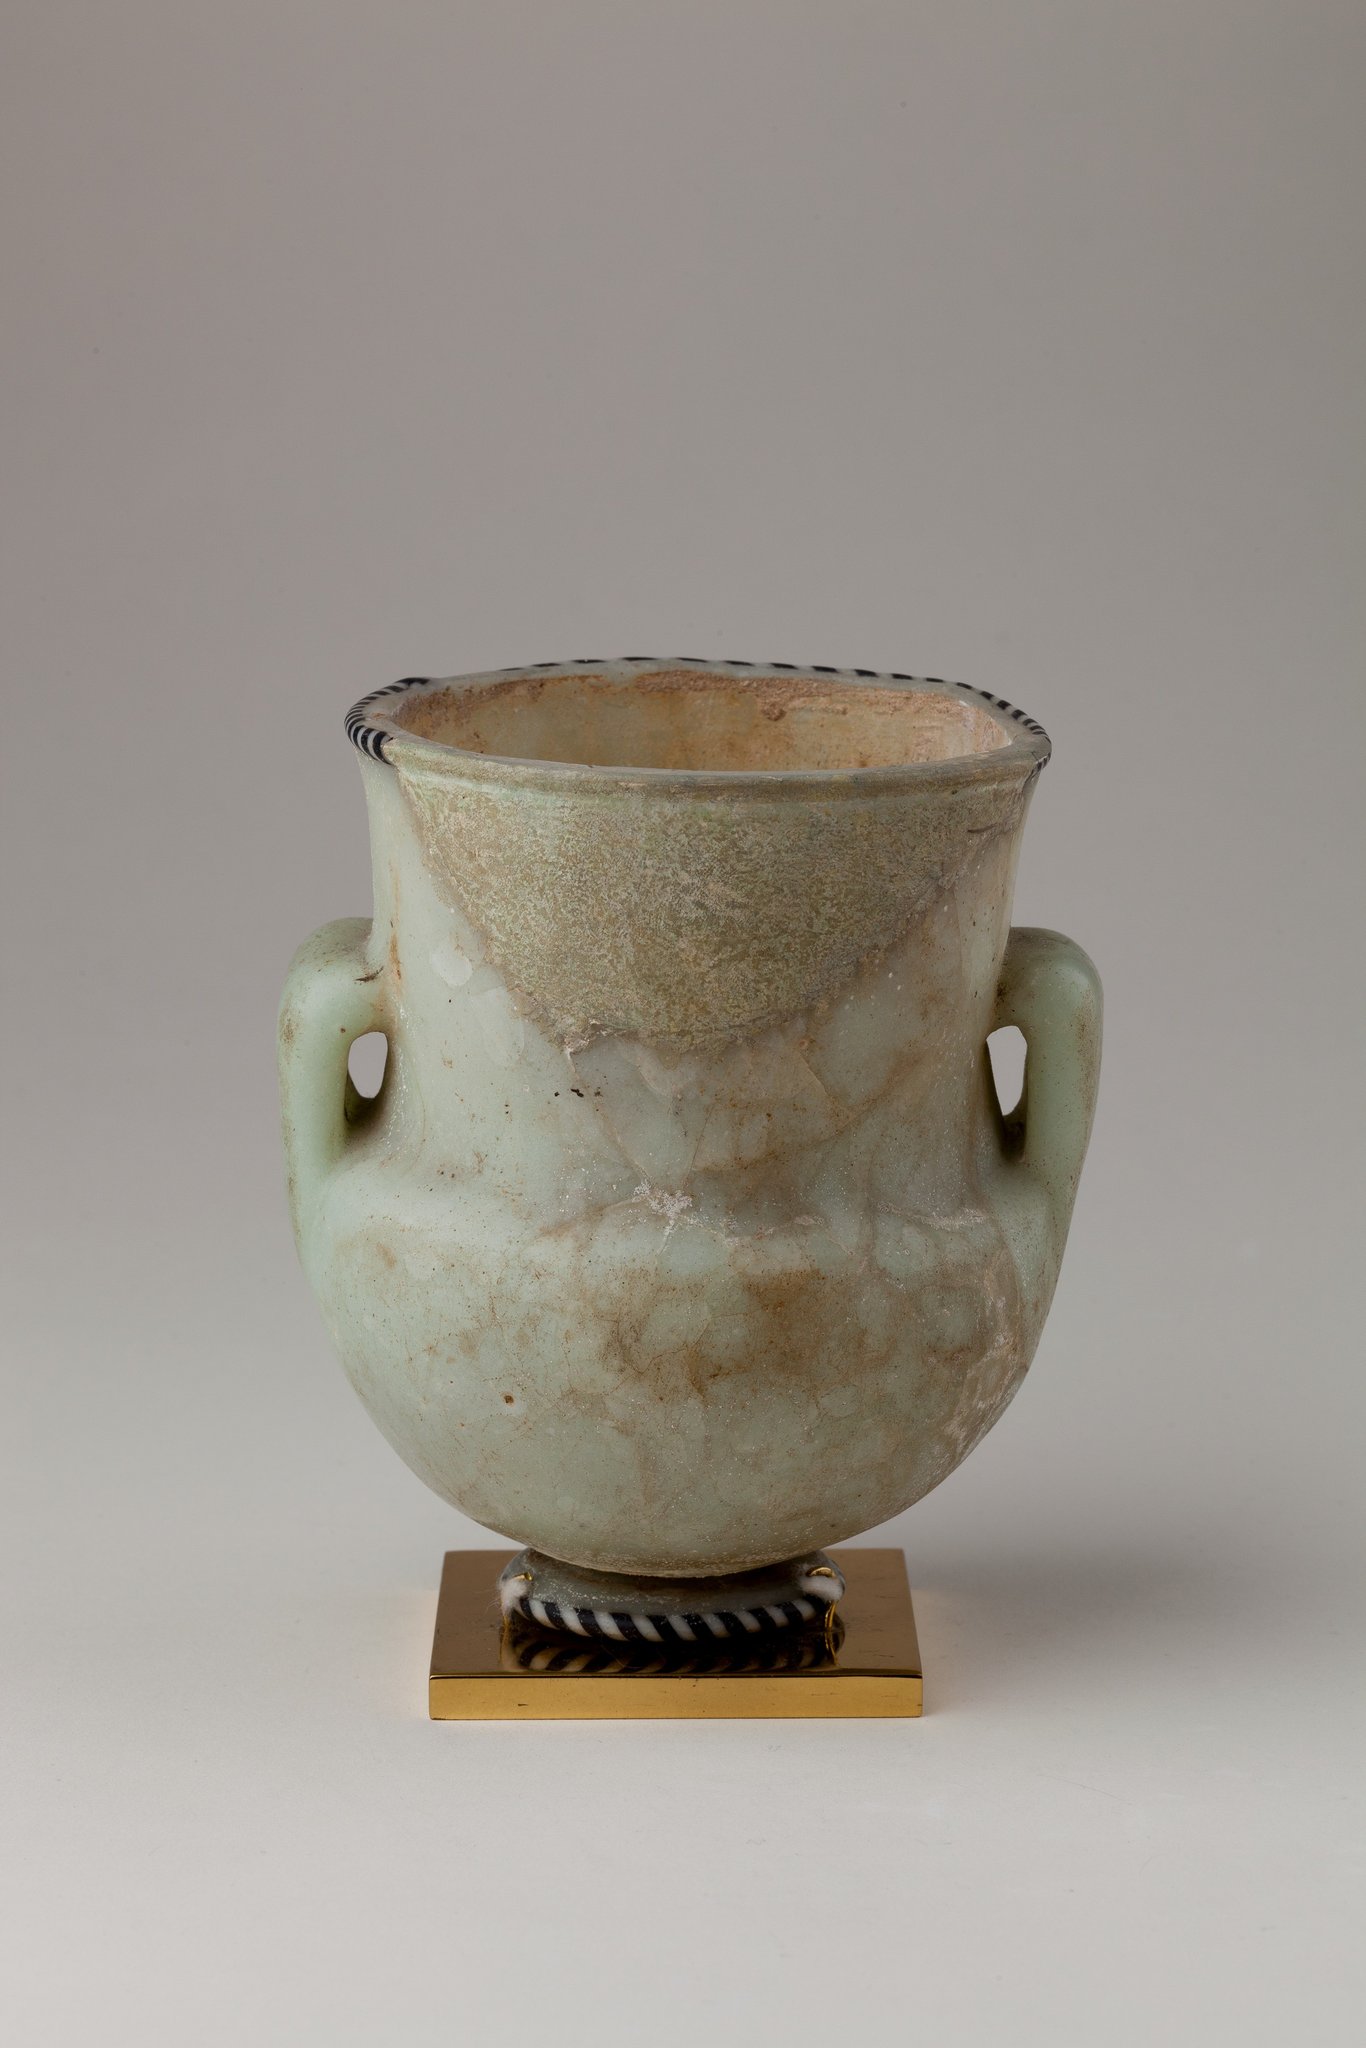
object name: jar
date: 1295-1070 BCE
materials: glass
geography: egypt